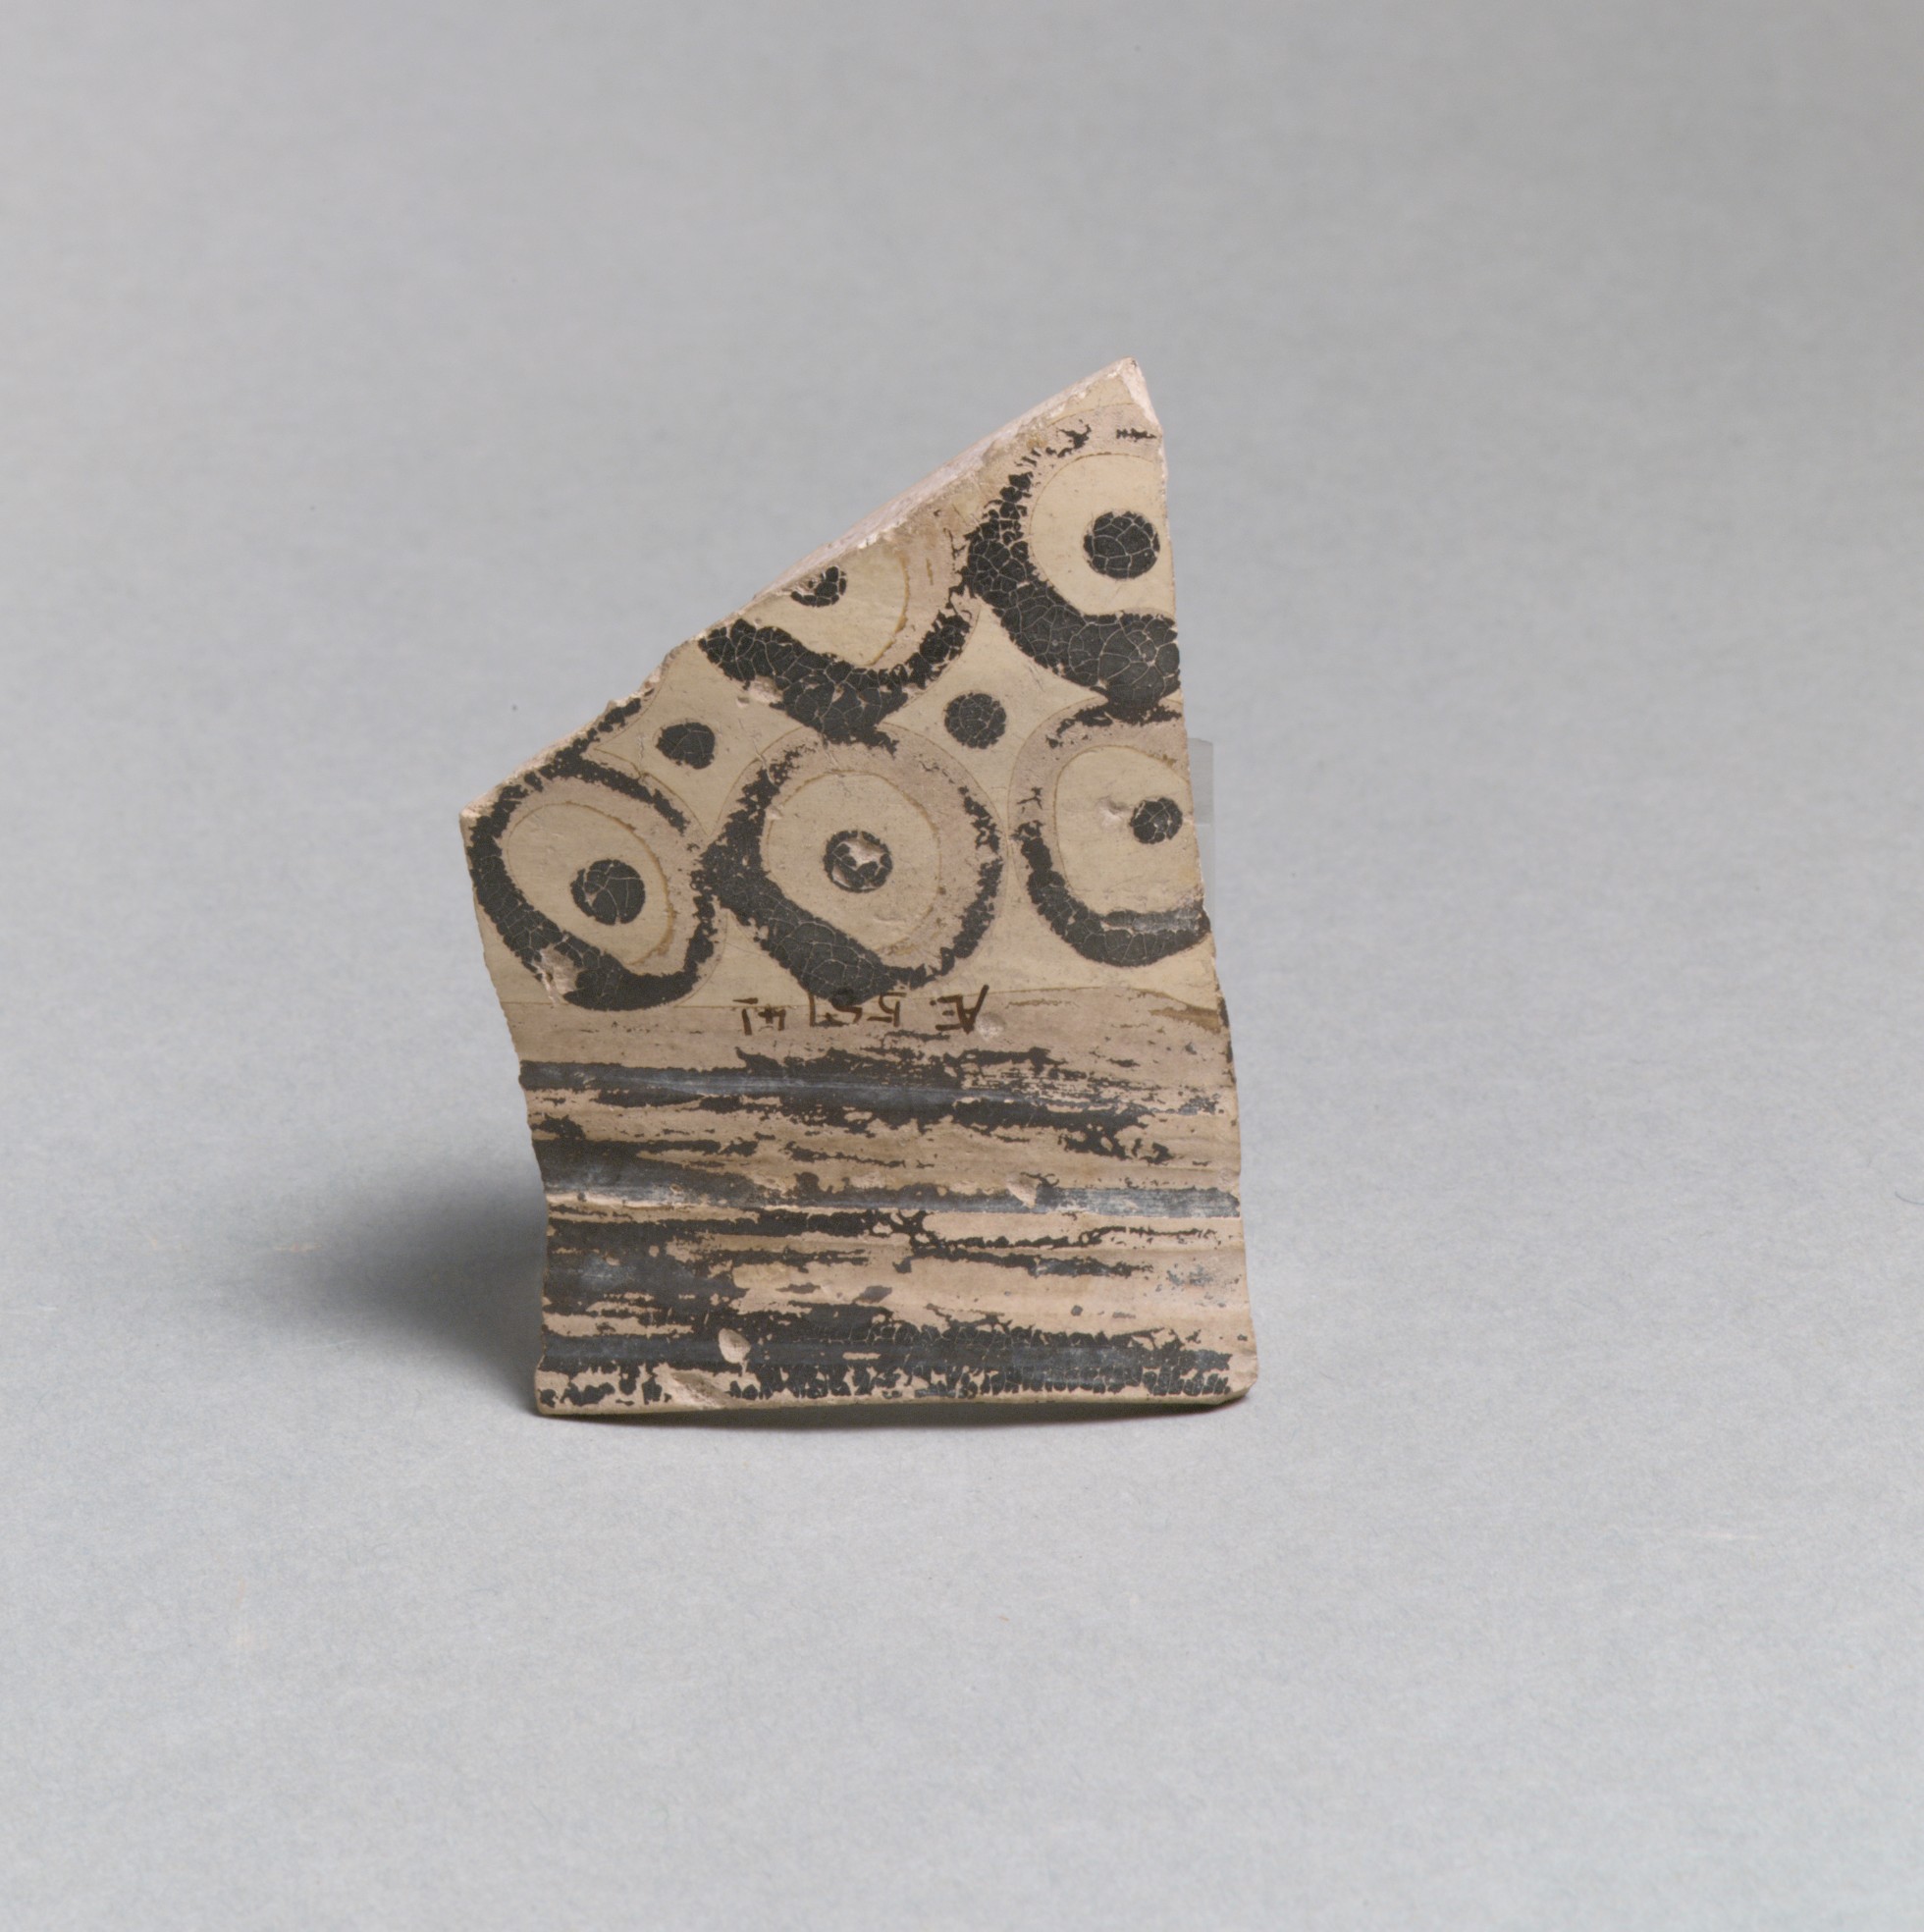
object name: vase fragment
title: Terracotta rim from a vase with bands and dots in circles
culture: minoan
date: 1450-1400 BCE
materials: terracotta